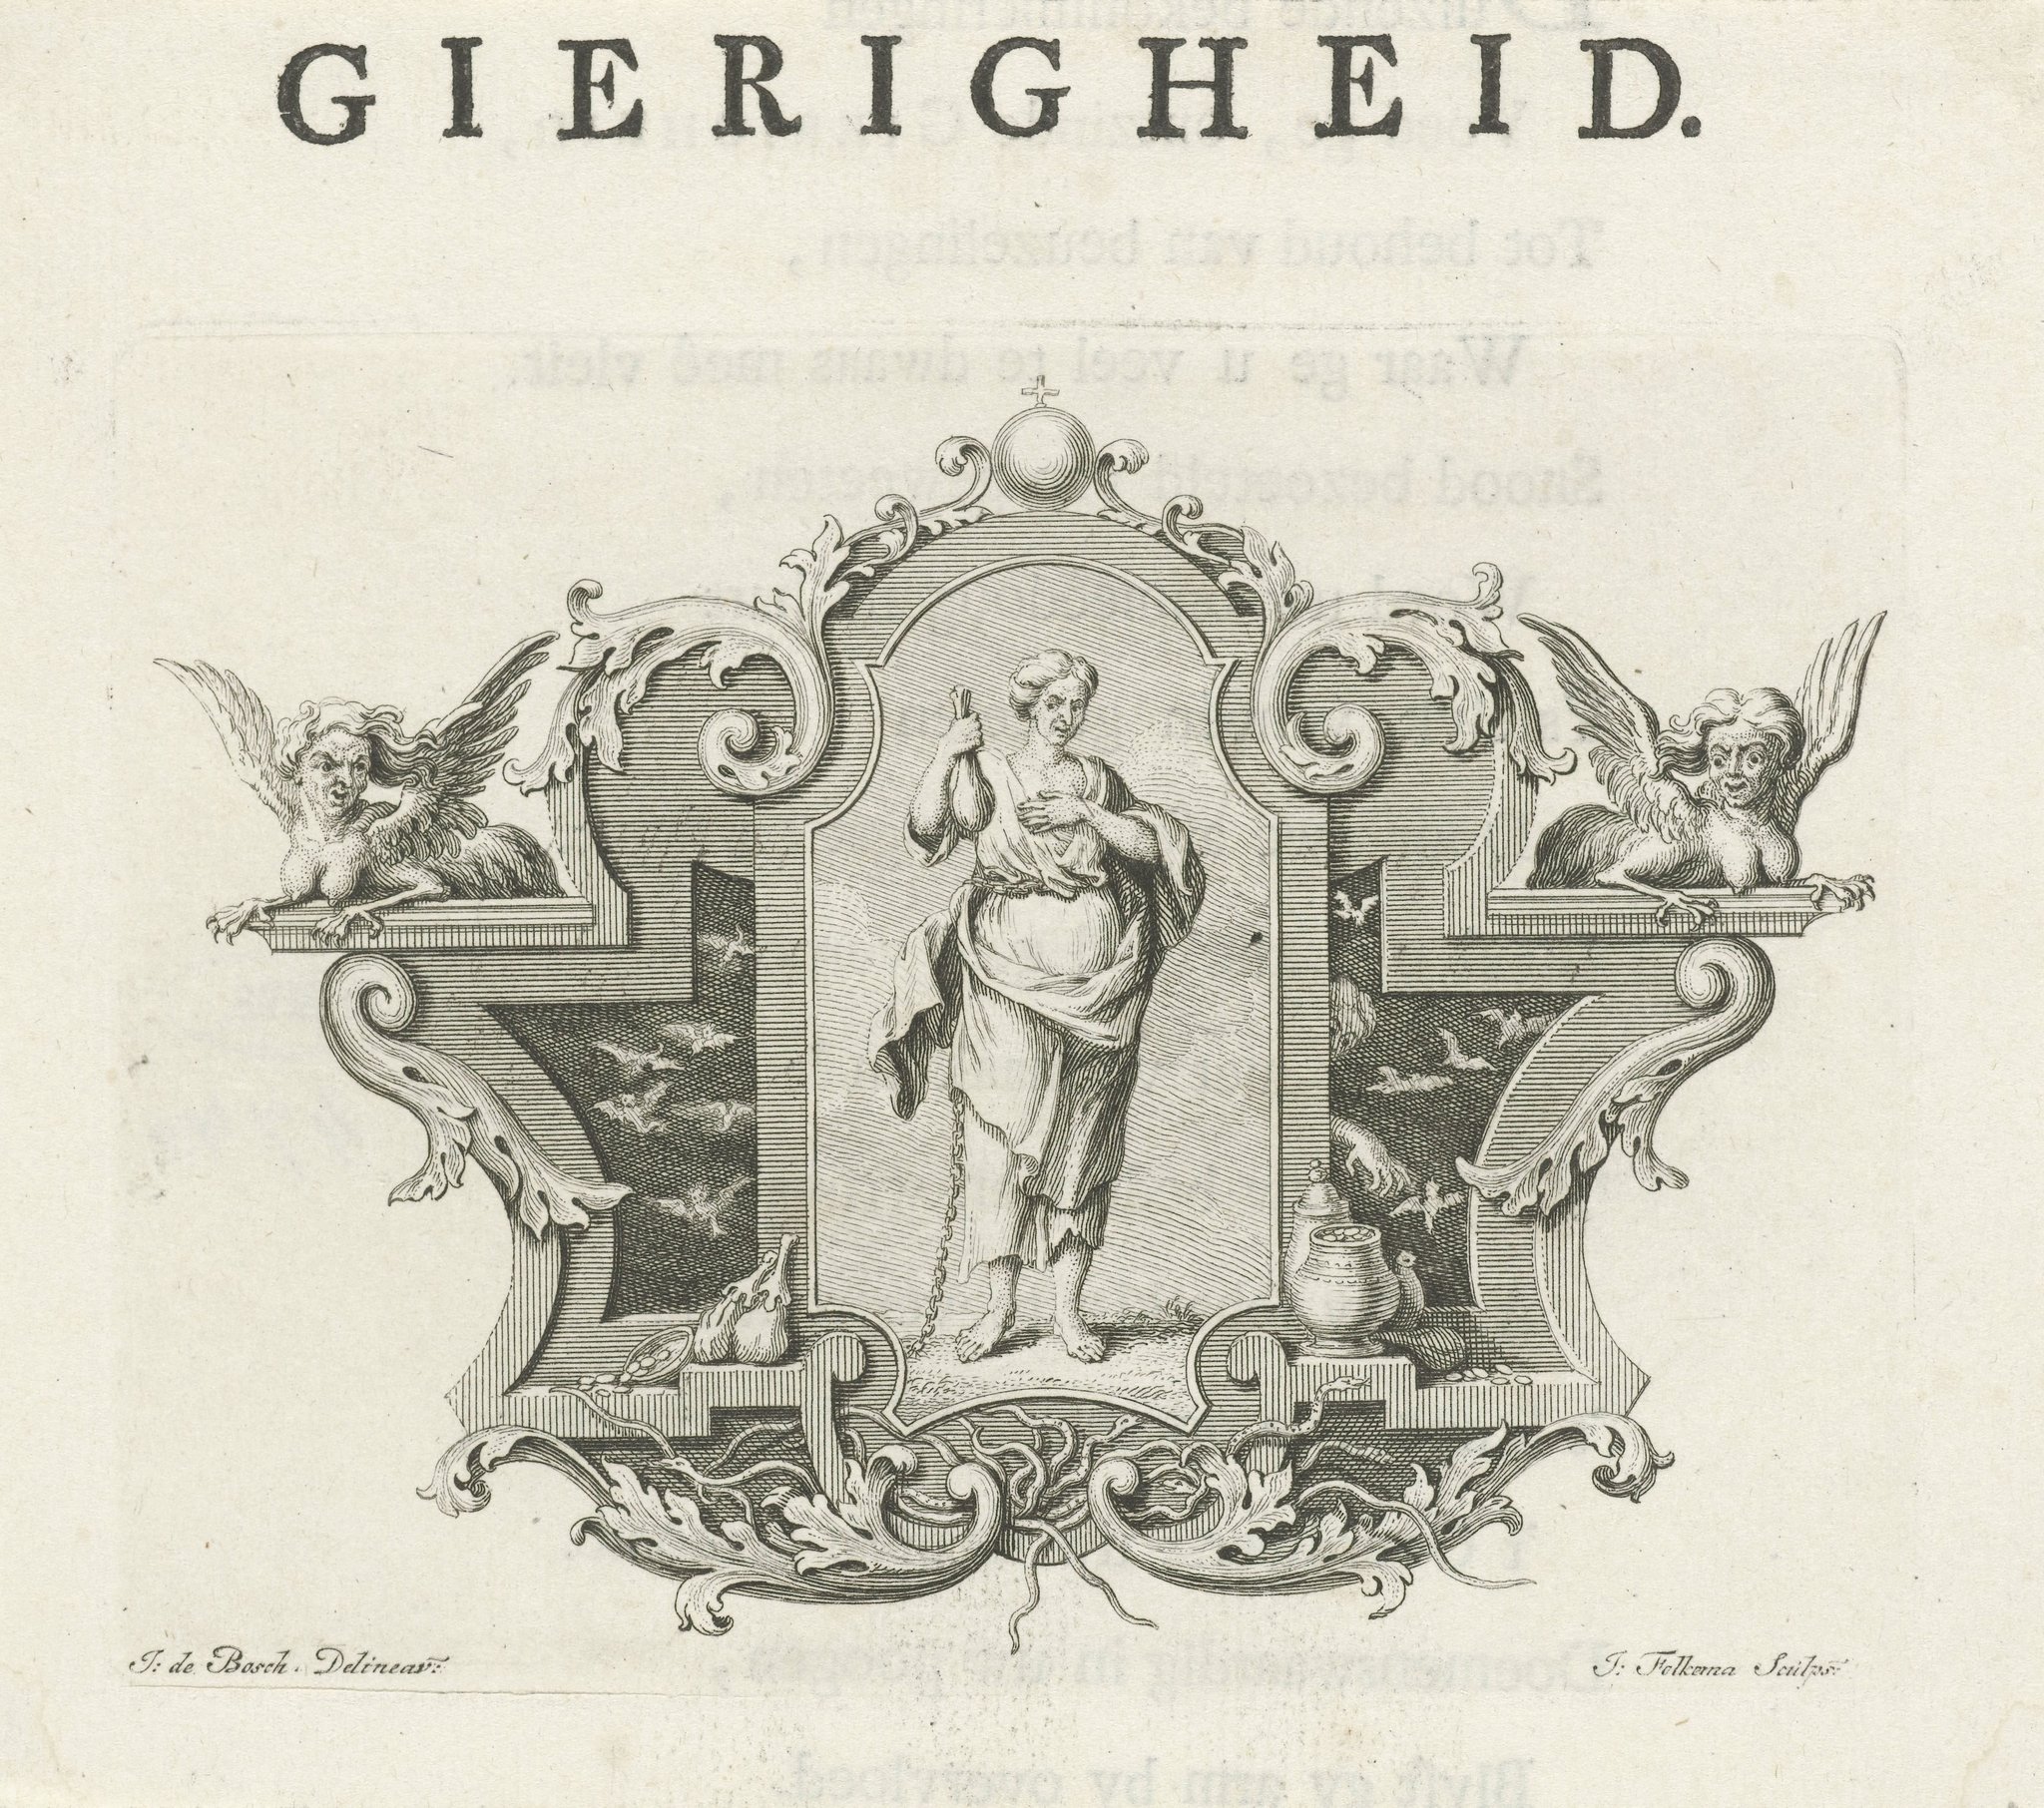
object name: book illustration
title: Gierigheid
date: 1723-1767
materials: paper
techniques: etching, letterpress printing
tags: covetousness; 'avaritia' (ripa) ~ personification of one of the seven deadly sins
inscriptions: collector's mark: Lugt 2228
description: Vignet met de beeltenis van de gepersonifieerde Gierigheid in een cartouche, omringd door duivelse figuren, slangen en geld. Ze houdt een geldzak in haar hand en draagt een ketting om haar middel. De prent maakt deel uit van een reeks boekillustraties over deugden en ondeugden.